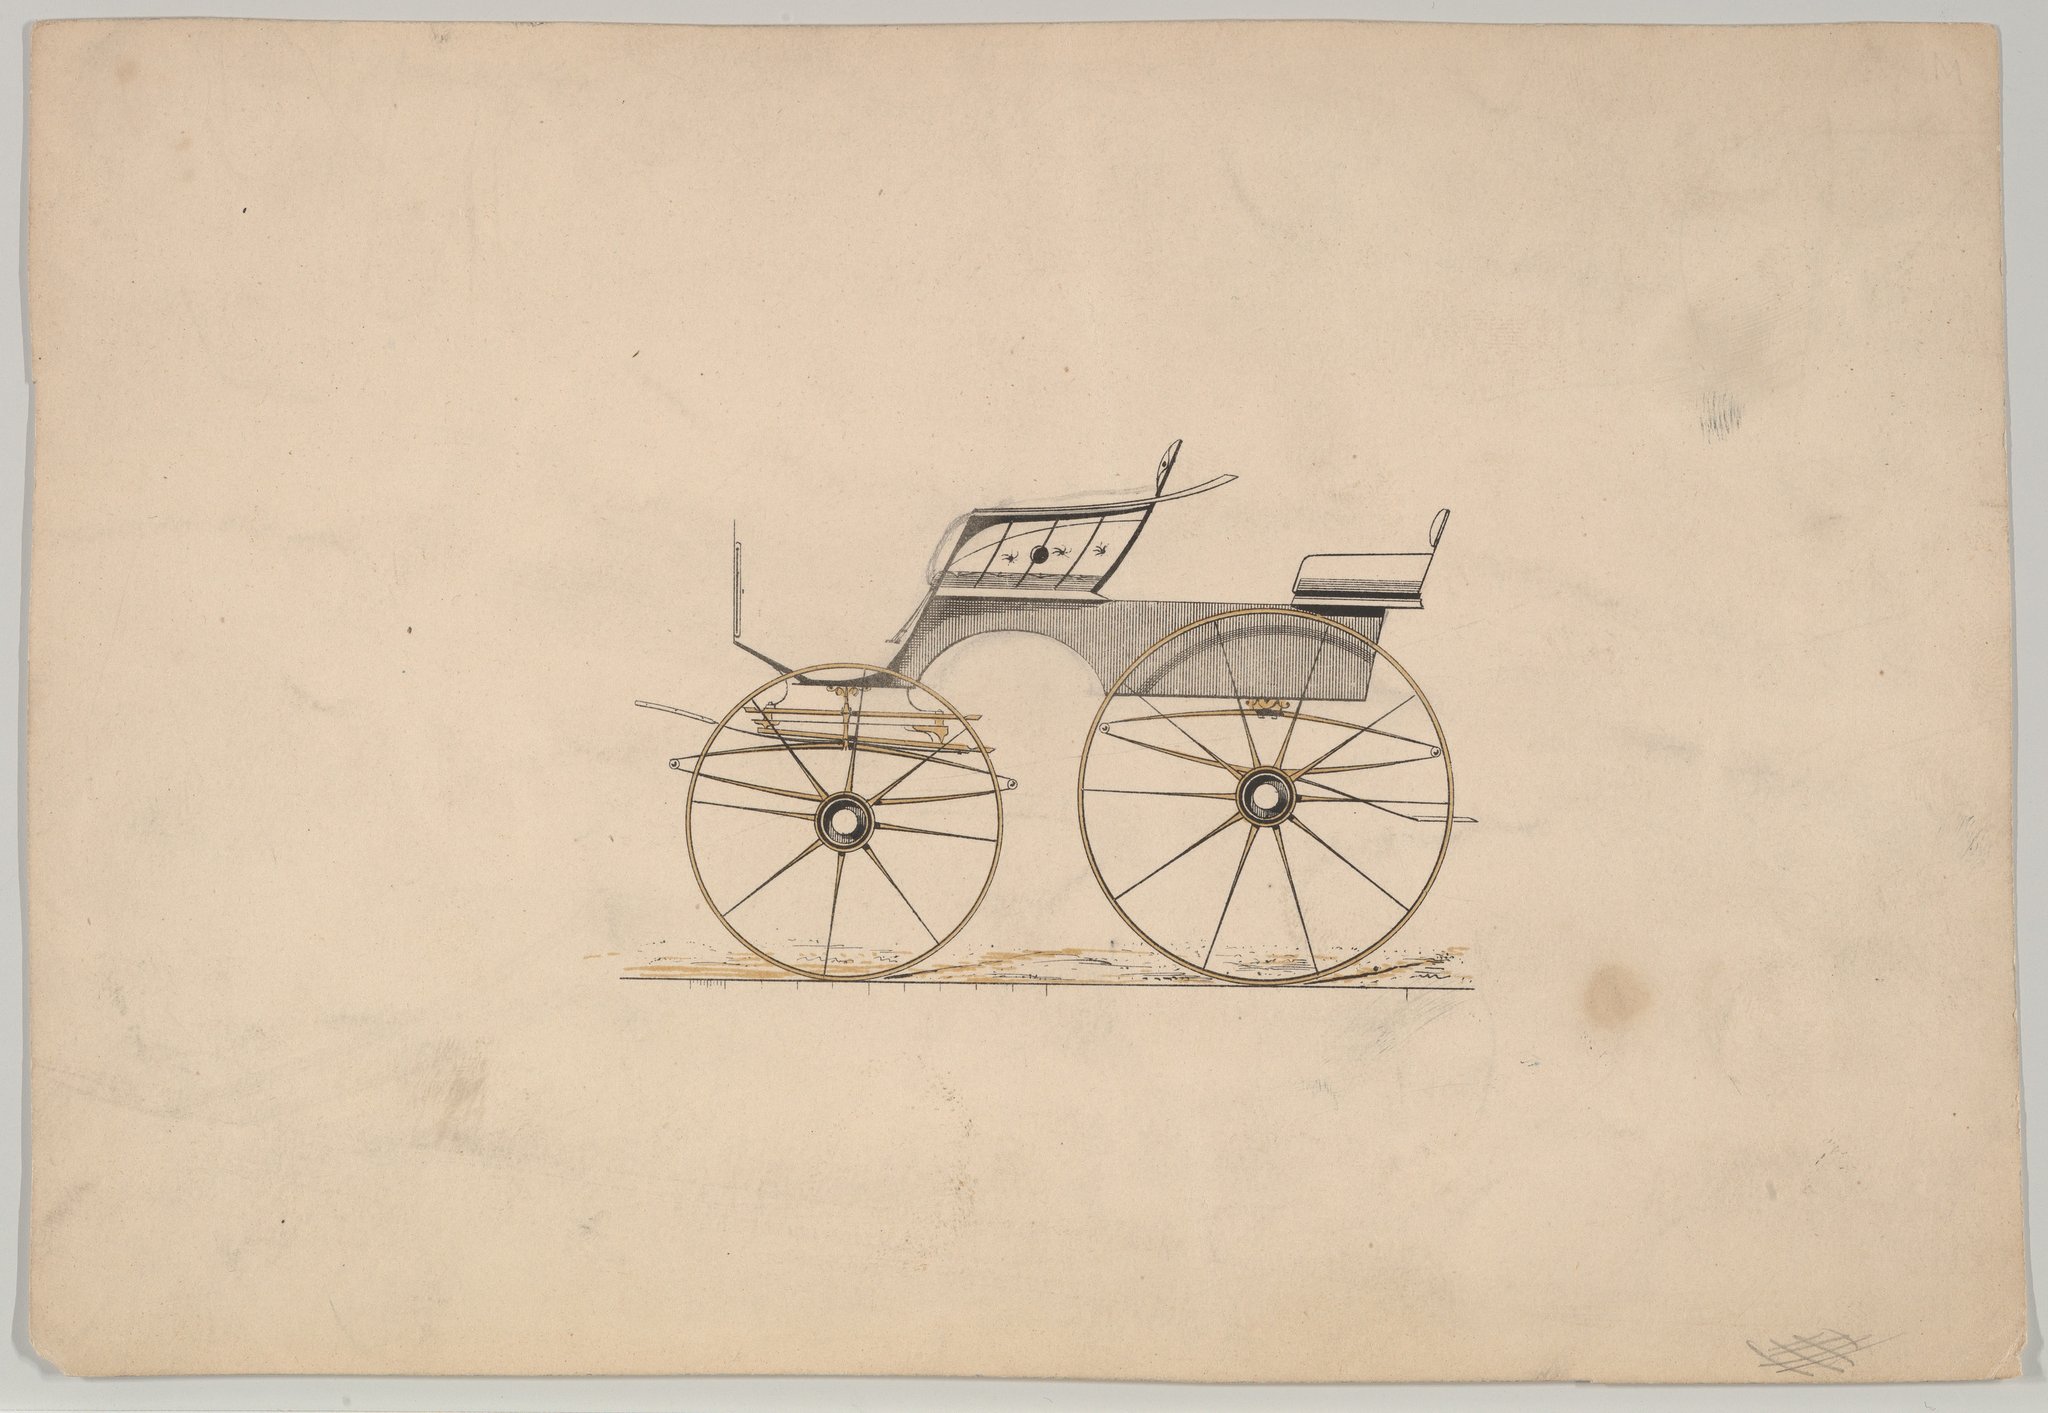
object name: drawing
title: T-Cart Phaeton (unnumbered)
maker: brewster & co.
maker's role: manufacturer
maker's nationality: american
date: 1850-1870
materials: graphite, ink, watercolor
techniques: pen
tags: carriages